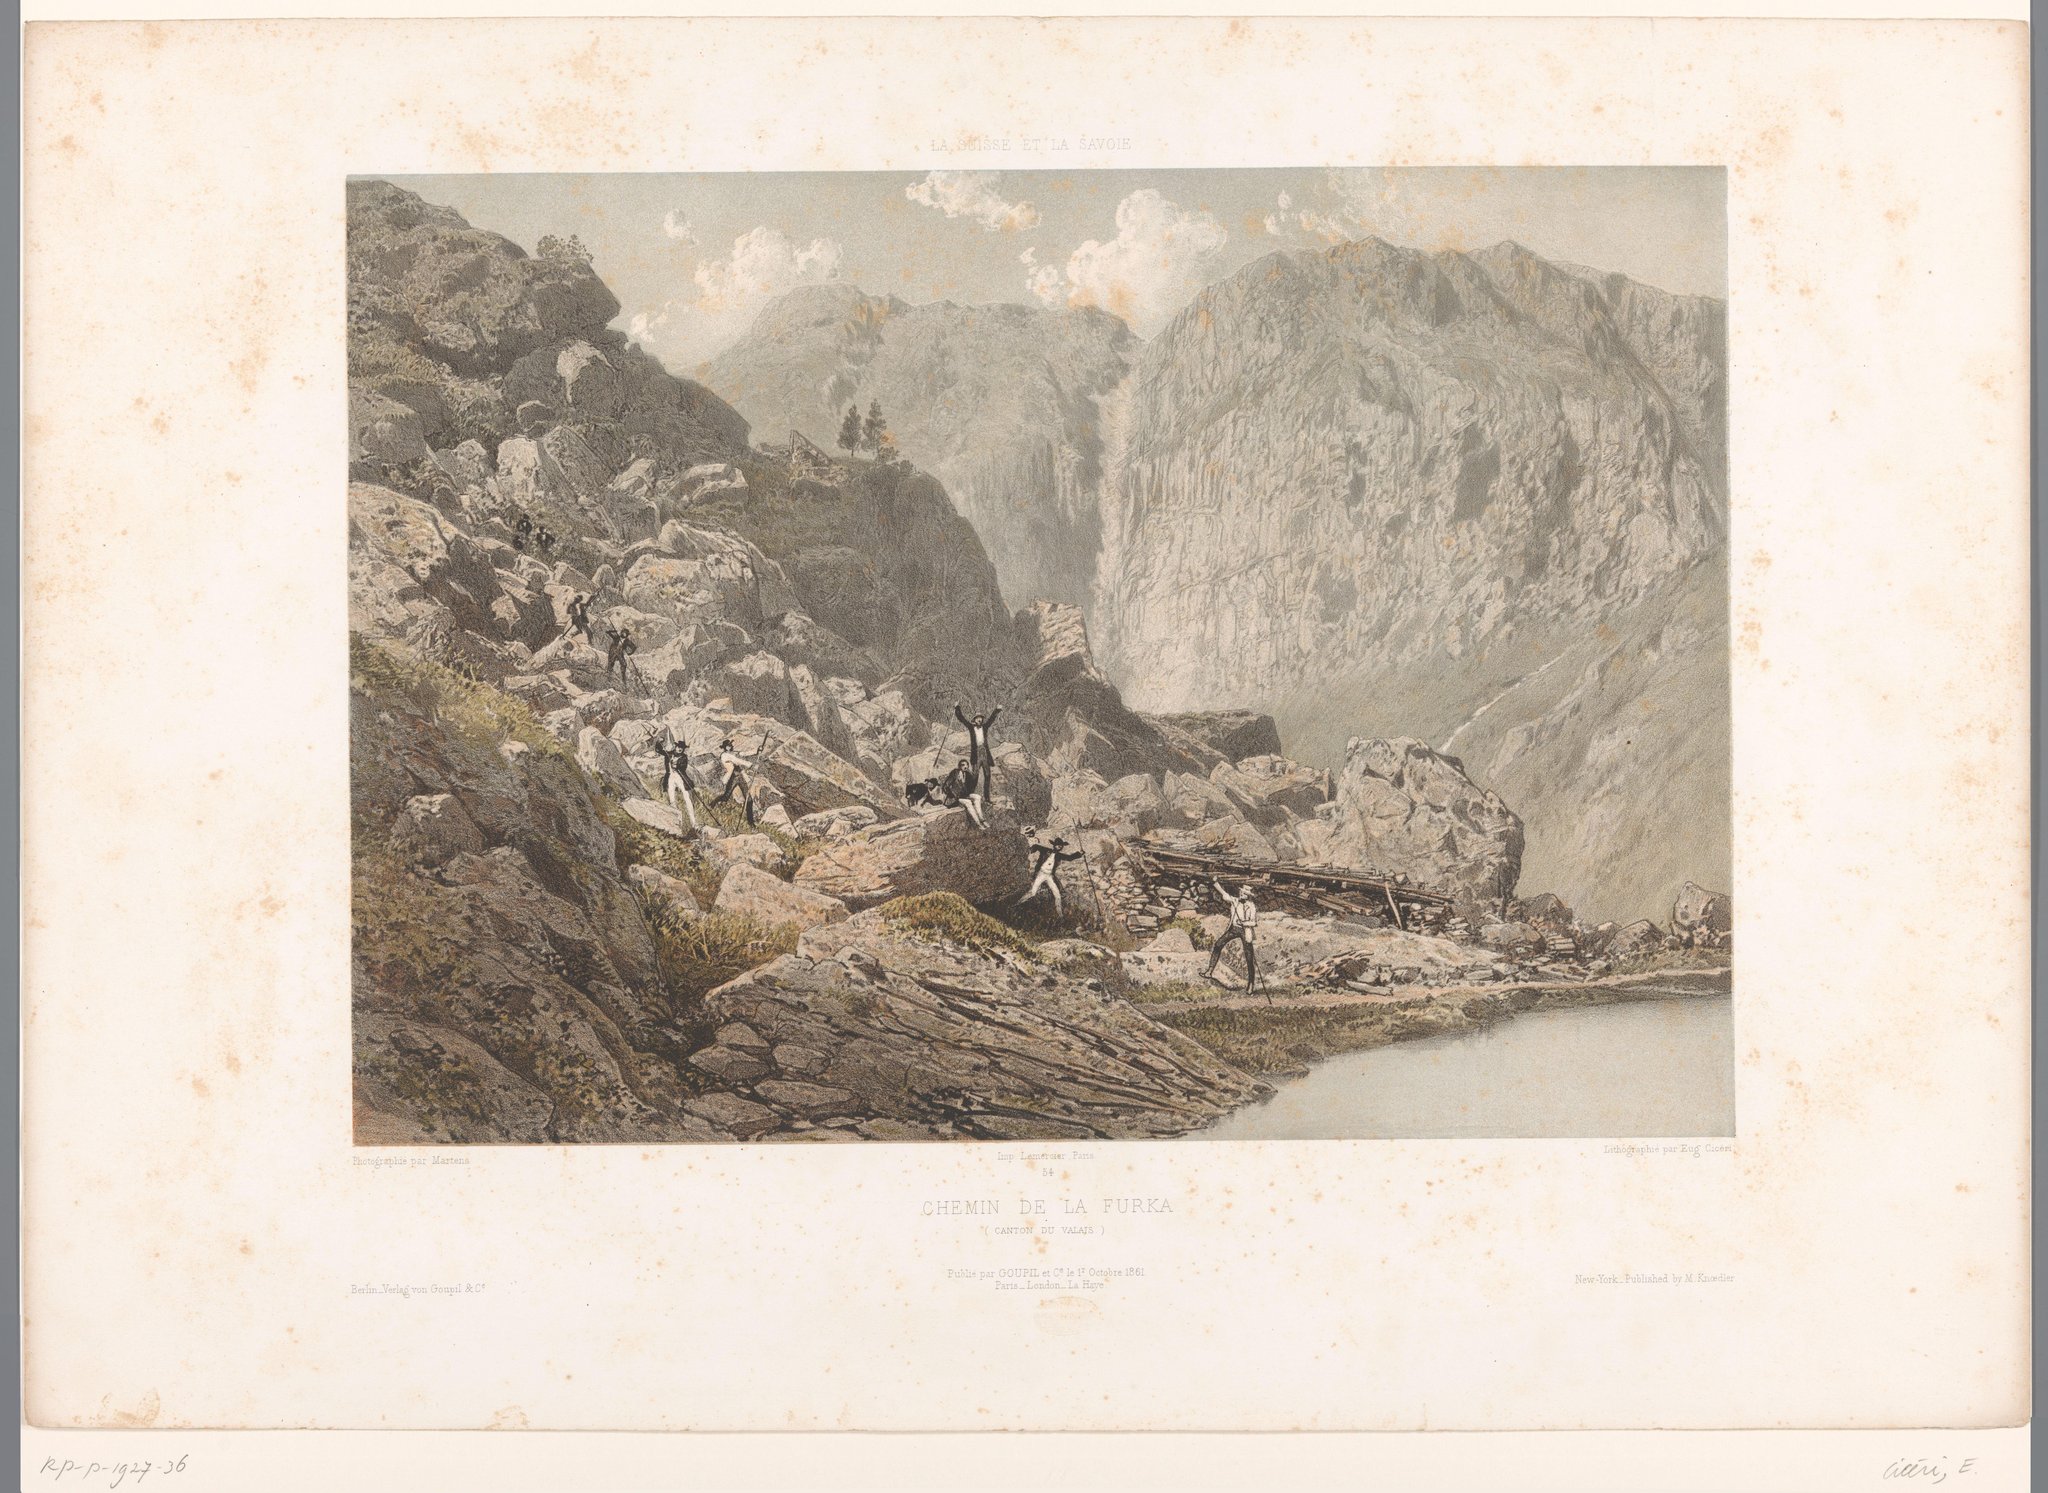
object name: print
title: La Suisse et la Savoie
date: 1859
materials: paper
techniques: lithograph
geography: new york city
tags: mountain climbing, mountaineering, lake, road, path, mountains (+ landscape with figures, staffage)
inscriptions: check stamp: Lugt 1090